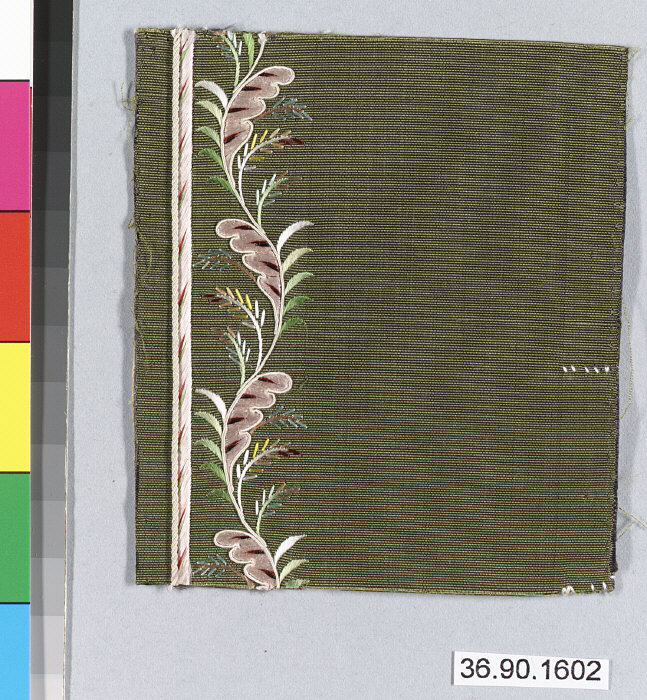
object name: sample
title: Embroidery sample for a man’s suit or waistcoat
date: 1785-1815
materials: silk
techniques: embroidery